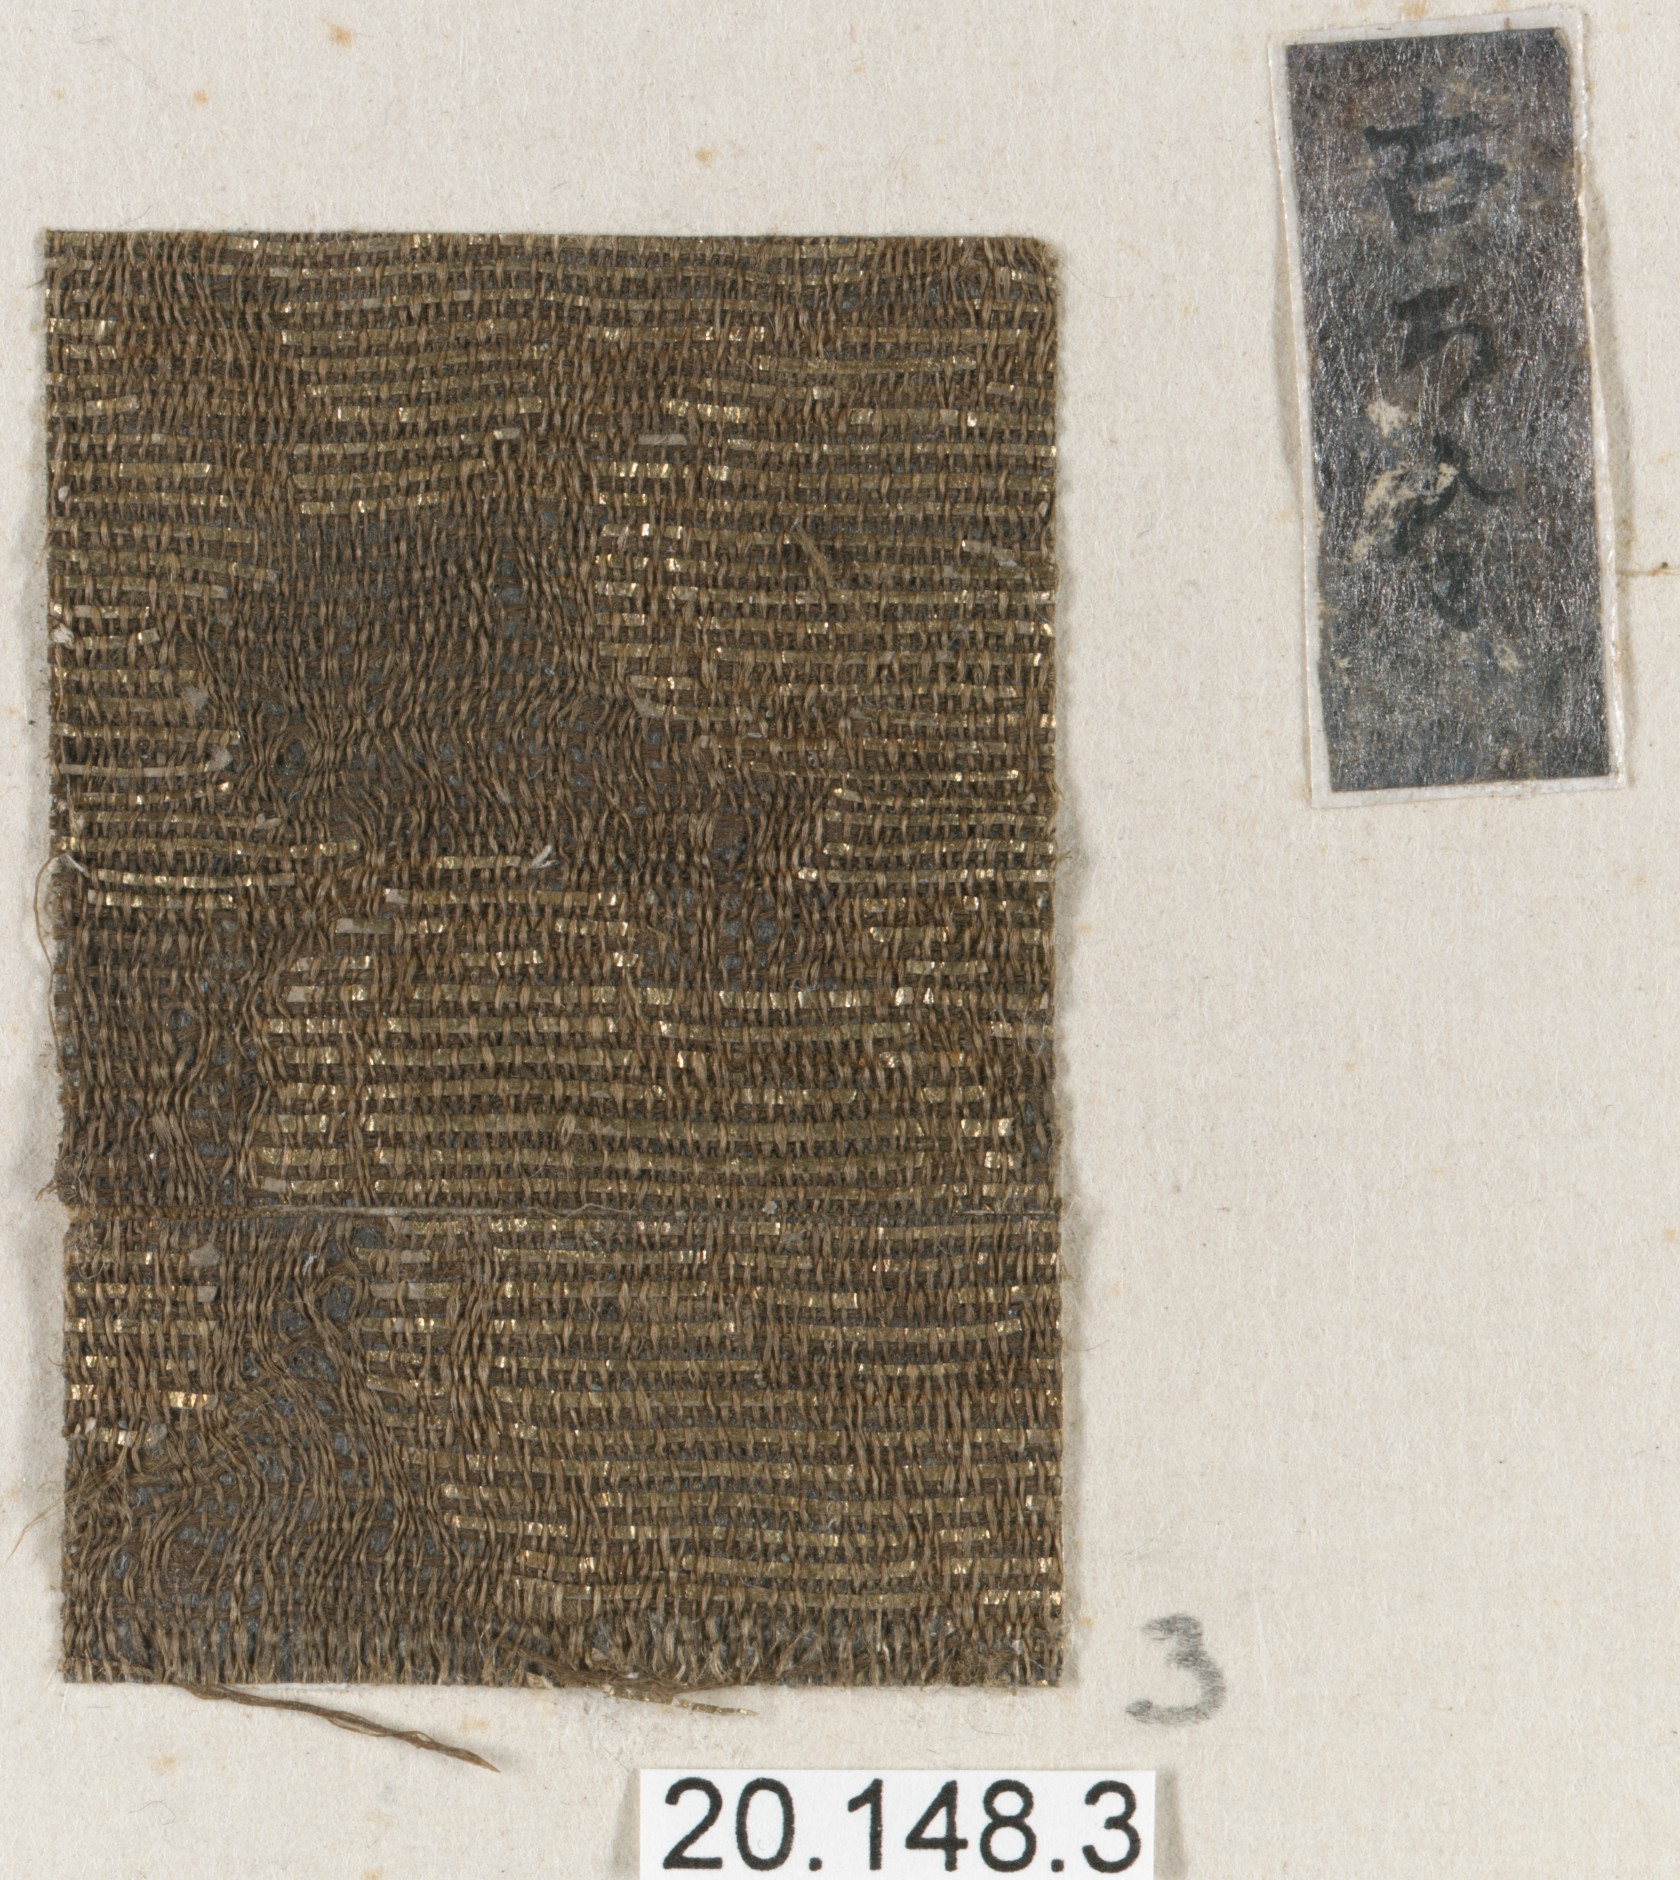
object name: piece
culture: japanese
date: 1301-1400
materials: silk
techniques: compound weave